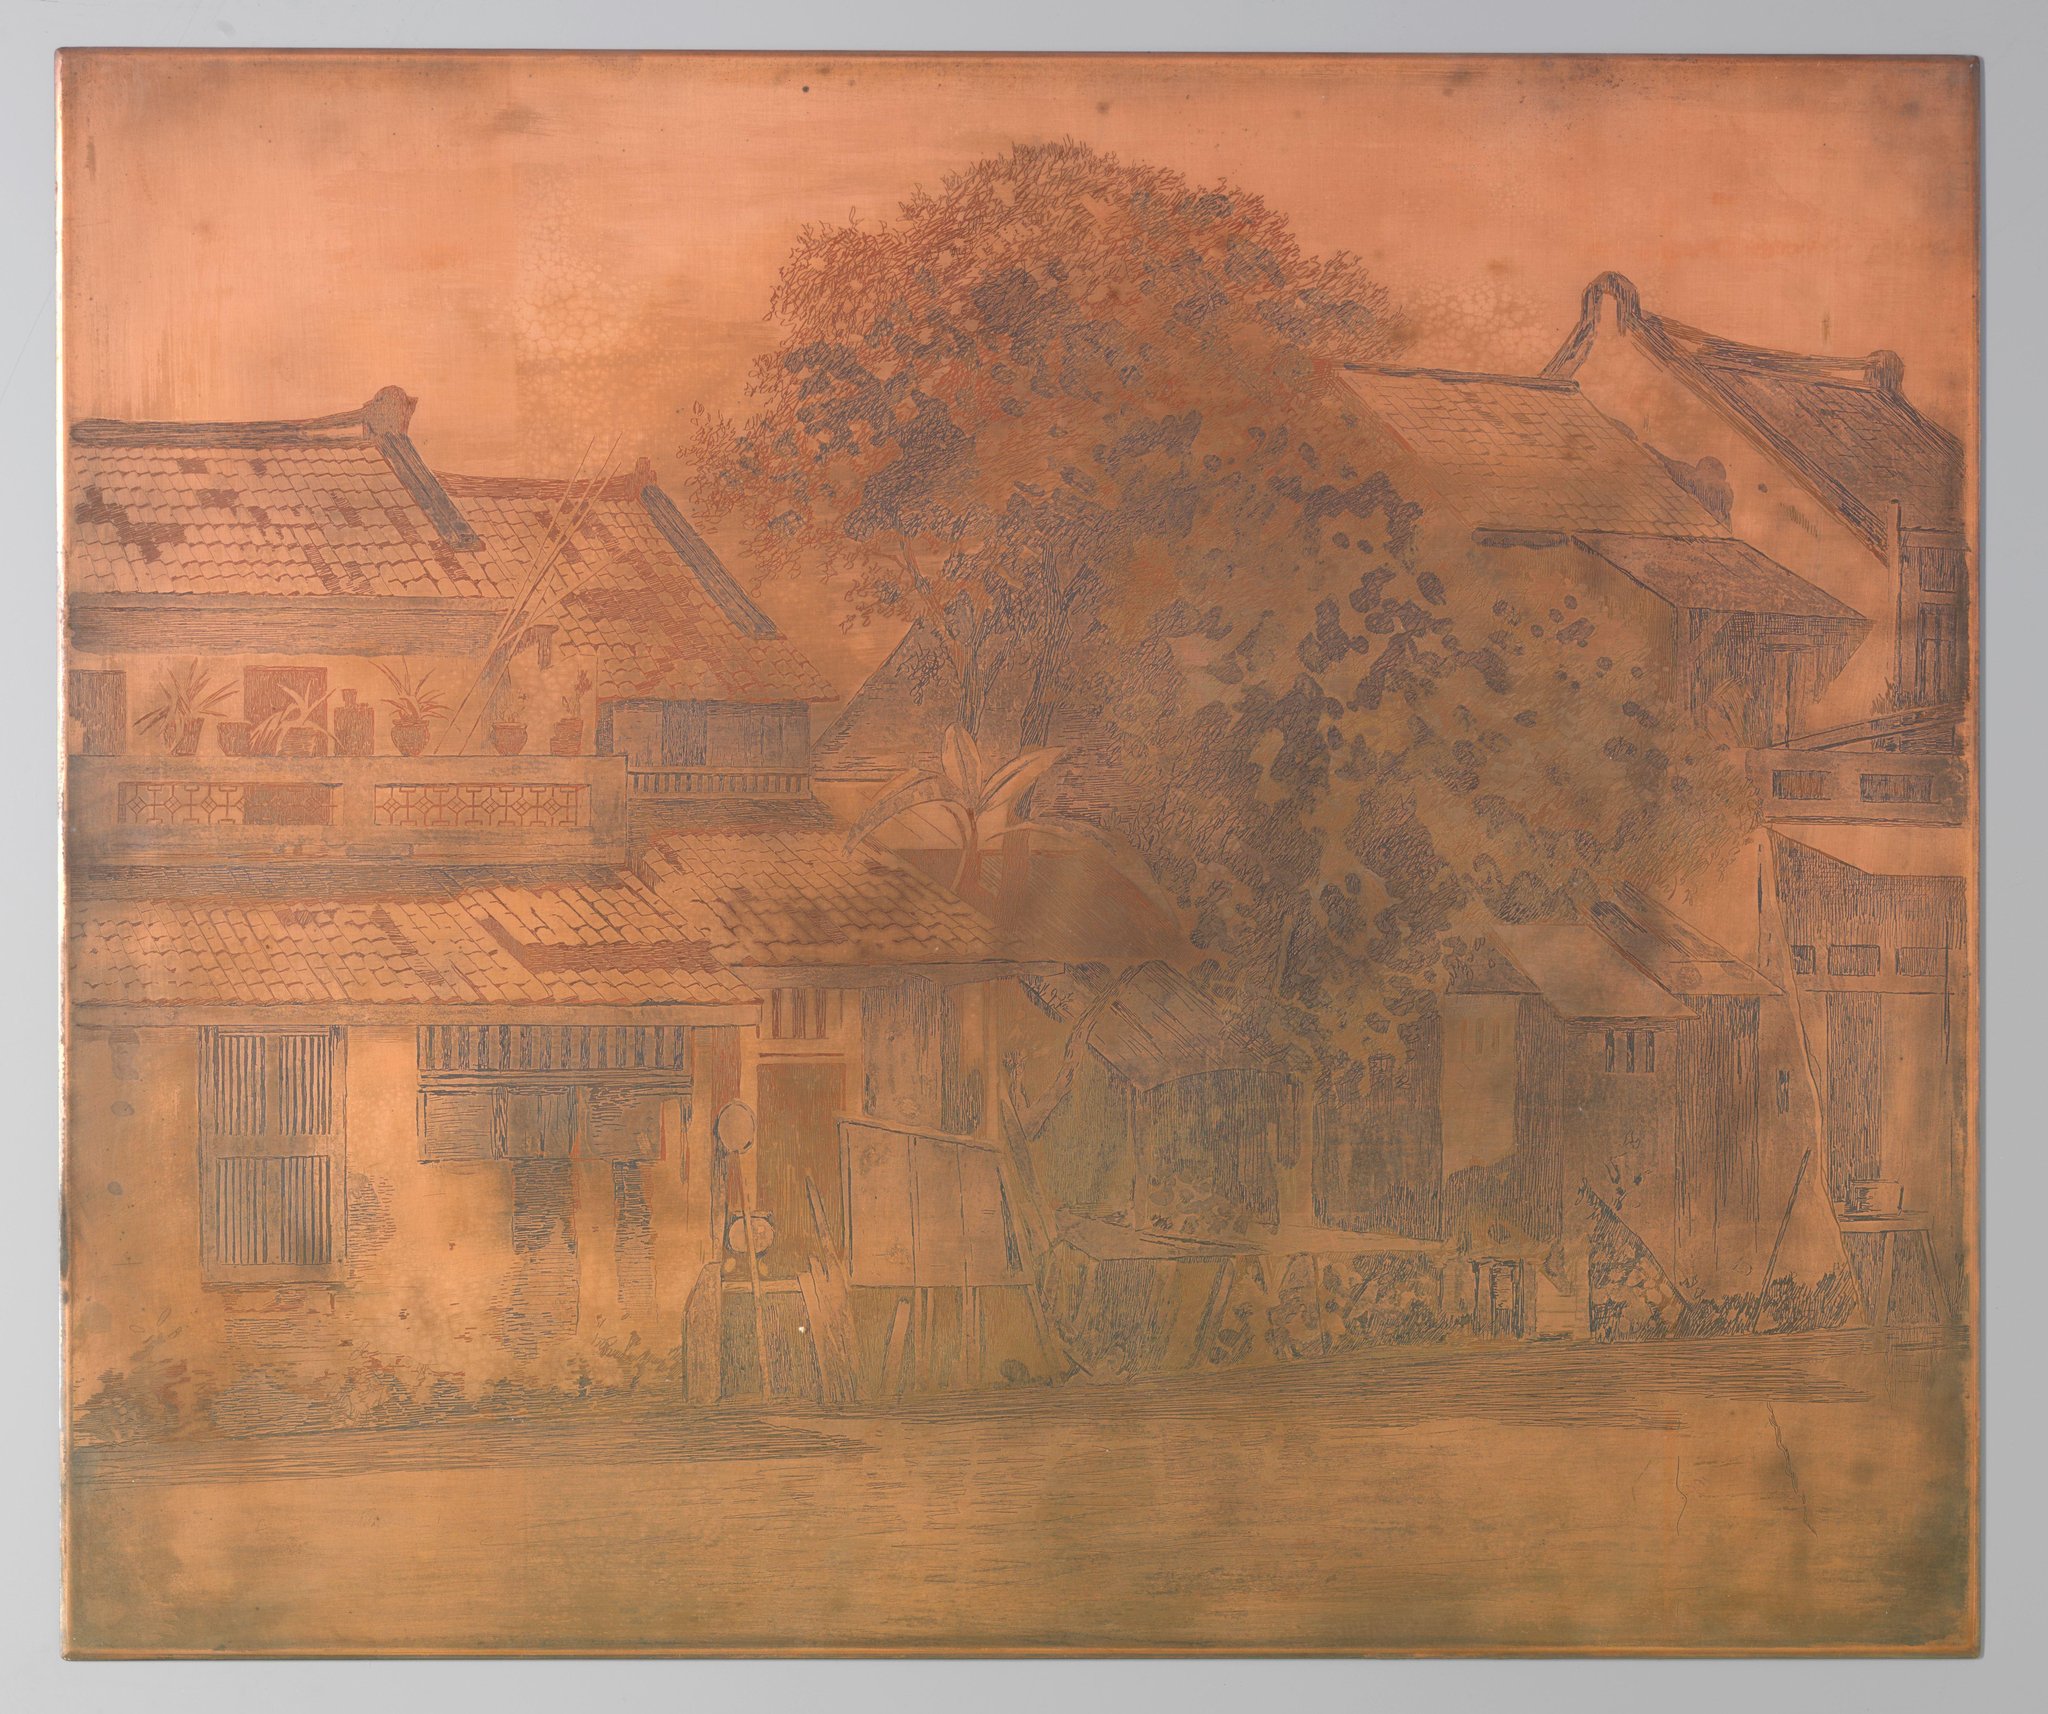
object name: copper plate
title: Batavia. Huizen aan de kali met bomen ertussen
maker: willem witsen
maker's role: draughtsman, painter, print maker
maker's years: 1860-1923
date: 1921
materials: copper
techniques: etching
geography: batavia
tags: batavia